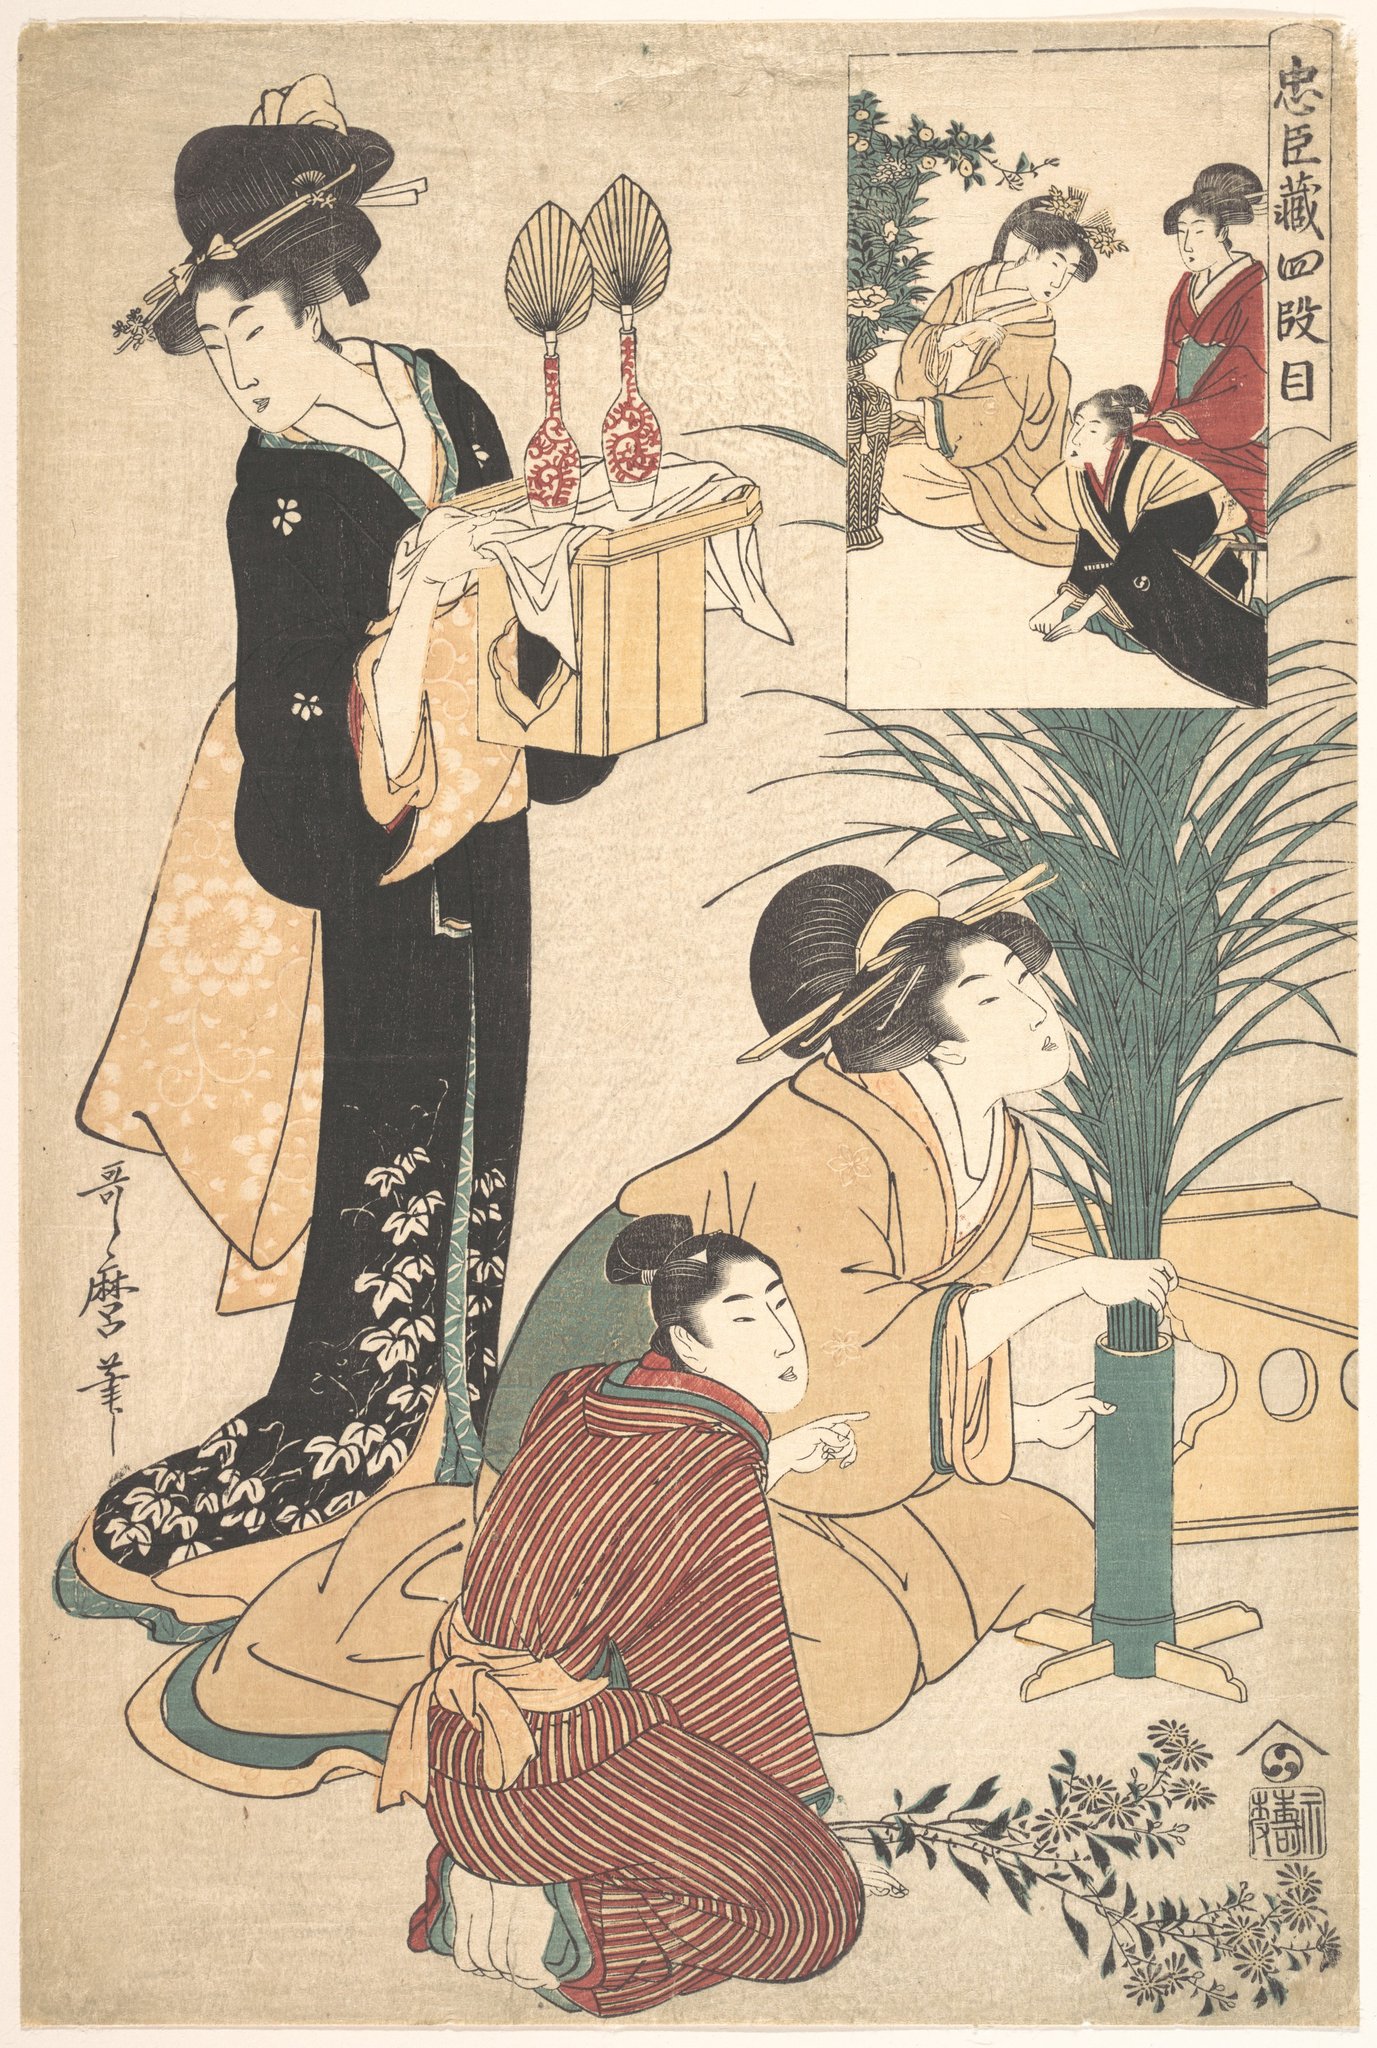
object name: print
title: A Woman and a Man Arranging Flowers for the Tsukimi (Moon Festival)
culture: japanese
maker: kitagawa utamaro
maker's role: artist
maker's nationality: japanese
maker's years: 1754-1806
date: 1802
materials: ink, paper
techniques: woodblock print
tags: men,women,flowers,working